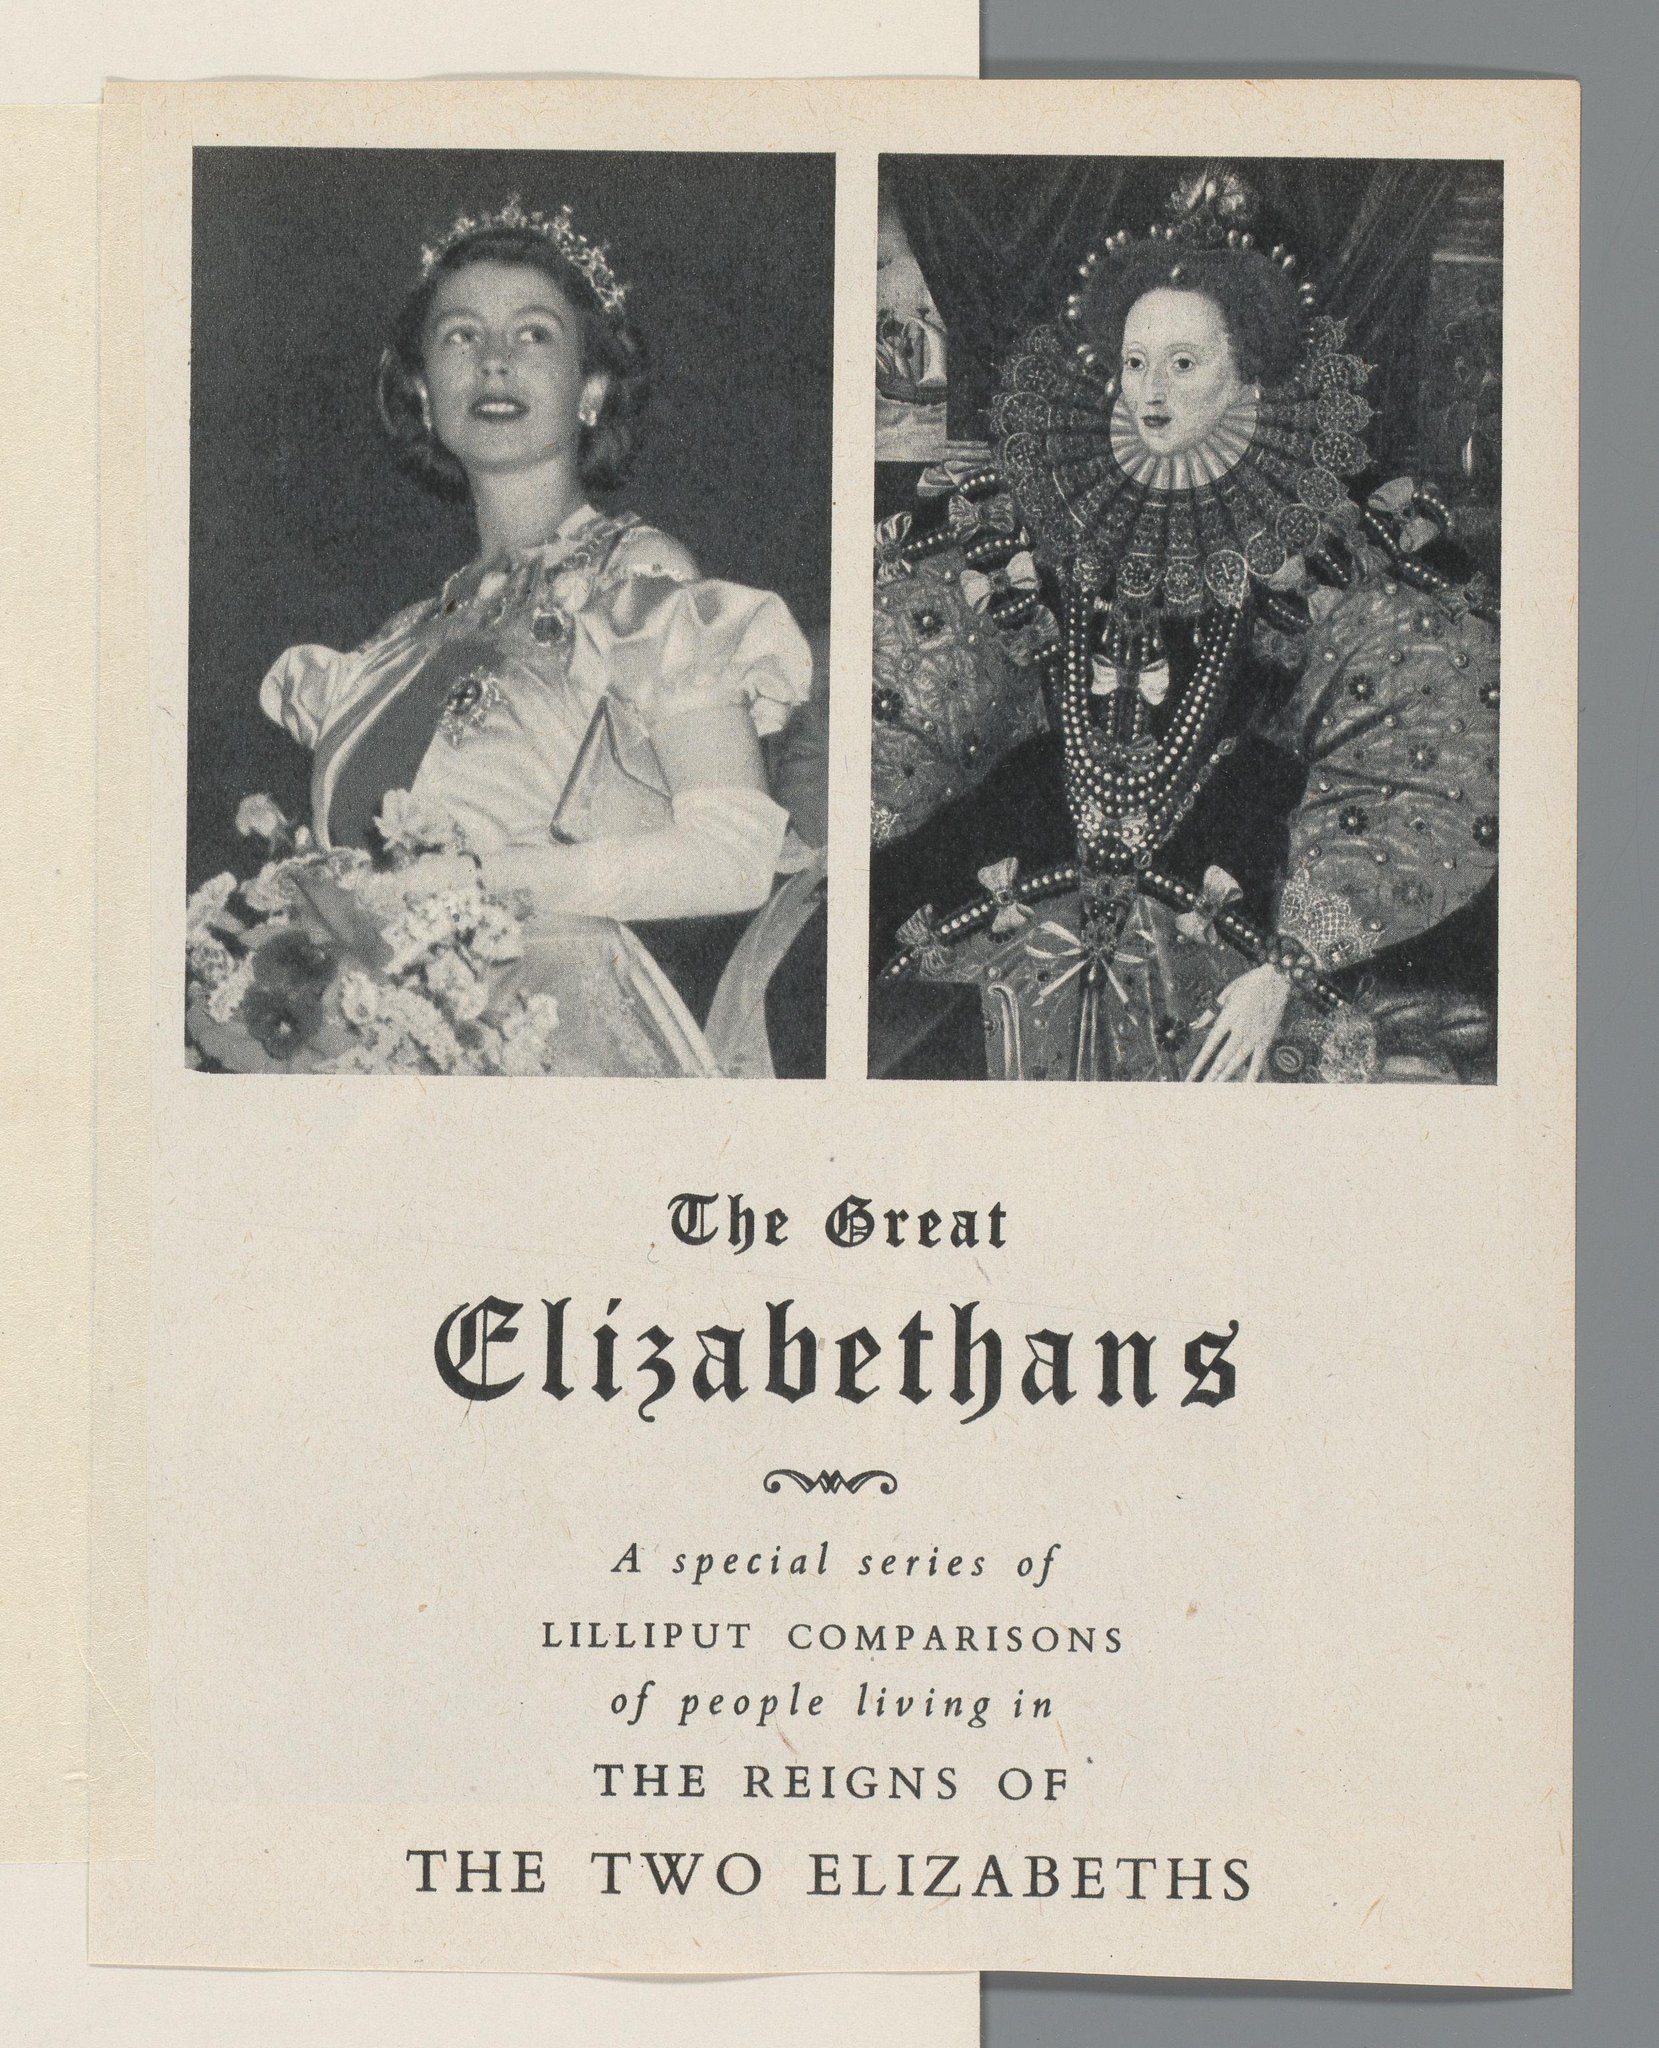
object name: photomechanical print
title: Portretten van Elizabeth I en II van Engeland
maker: Anonymous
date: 1952-1970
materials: paper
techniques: rotogravure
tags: historical persons - bb - woman, queen